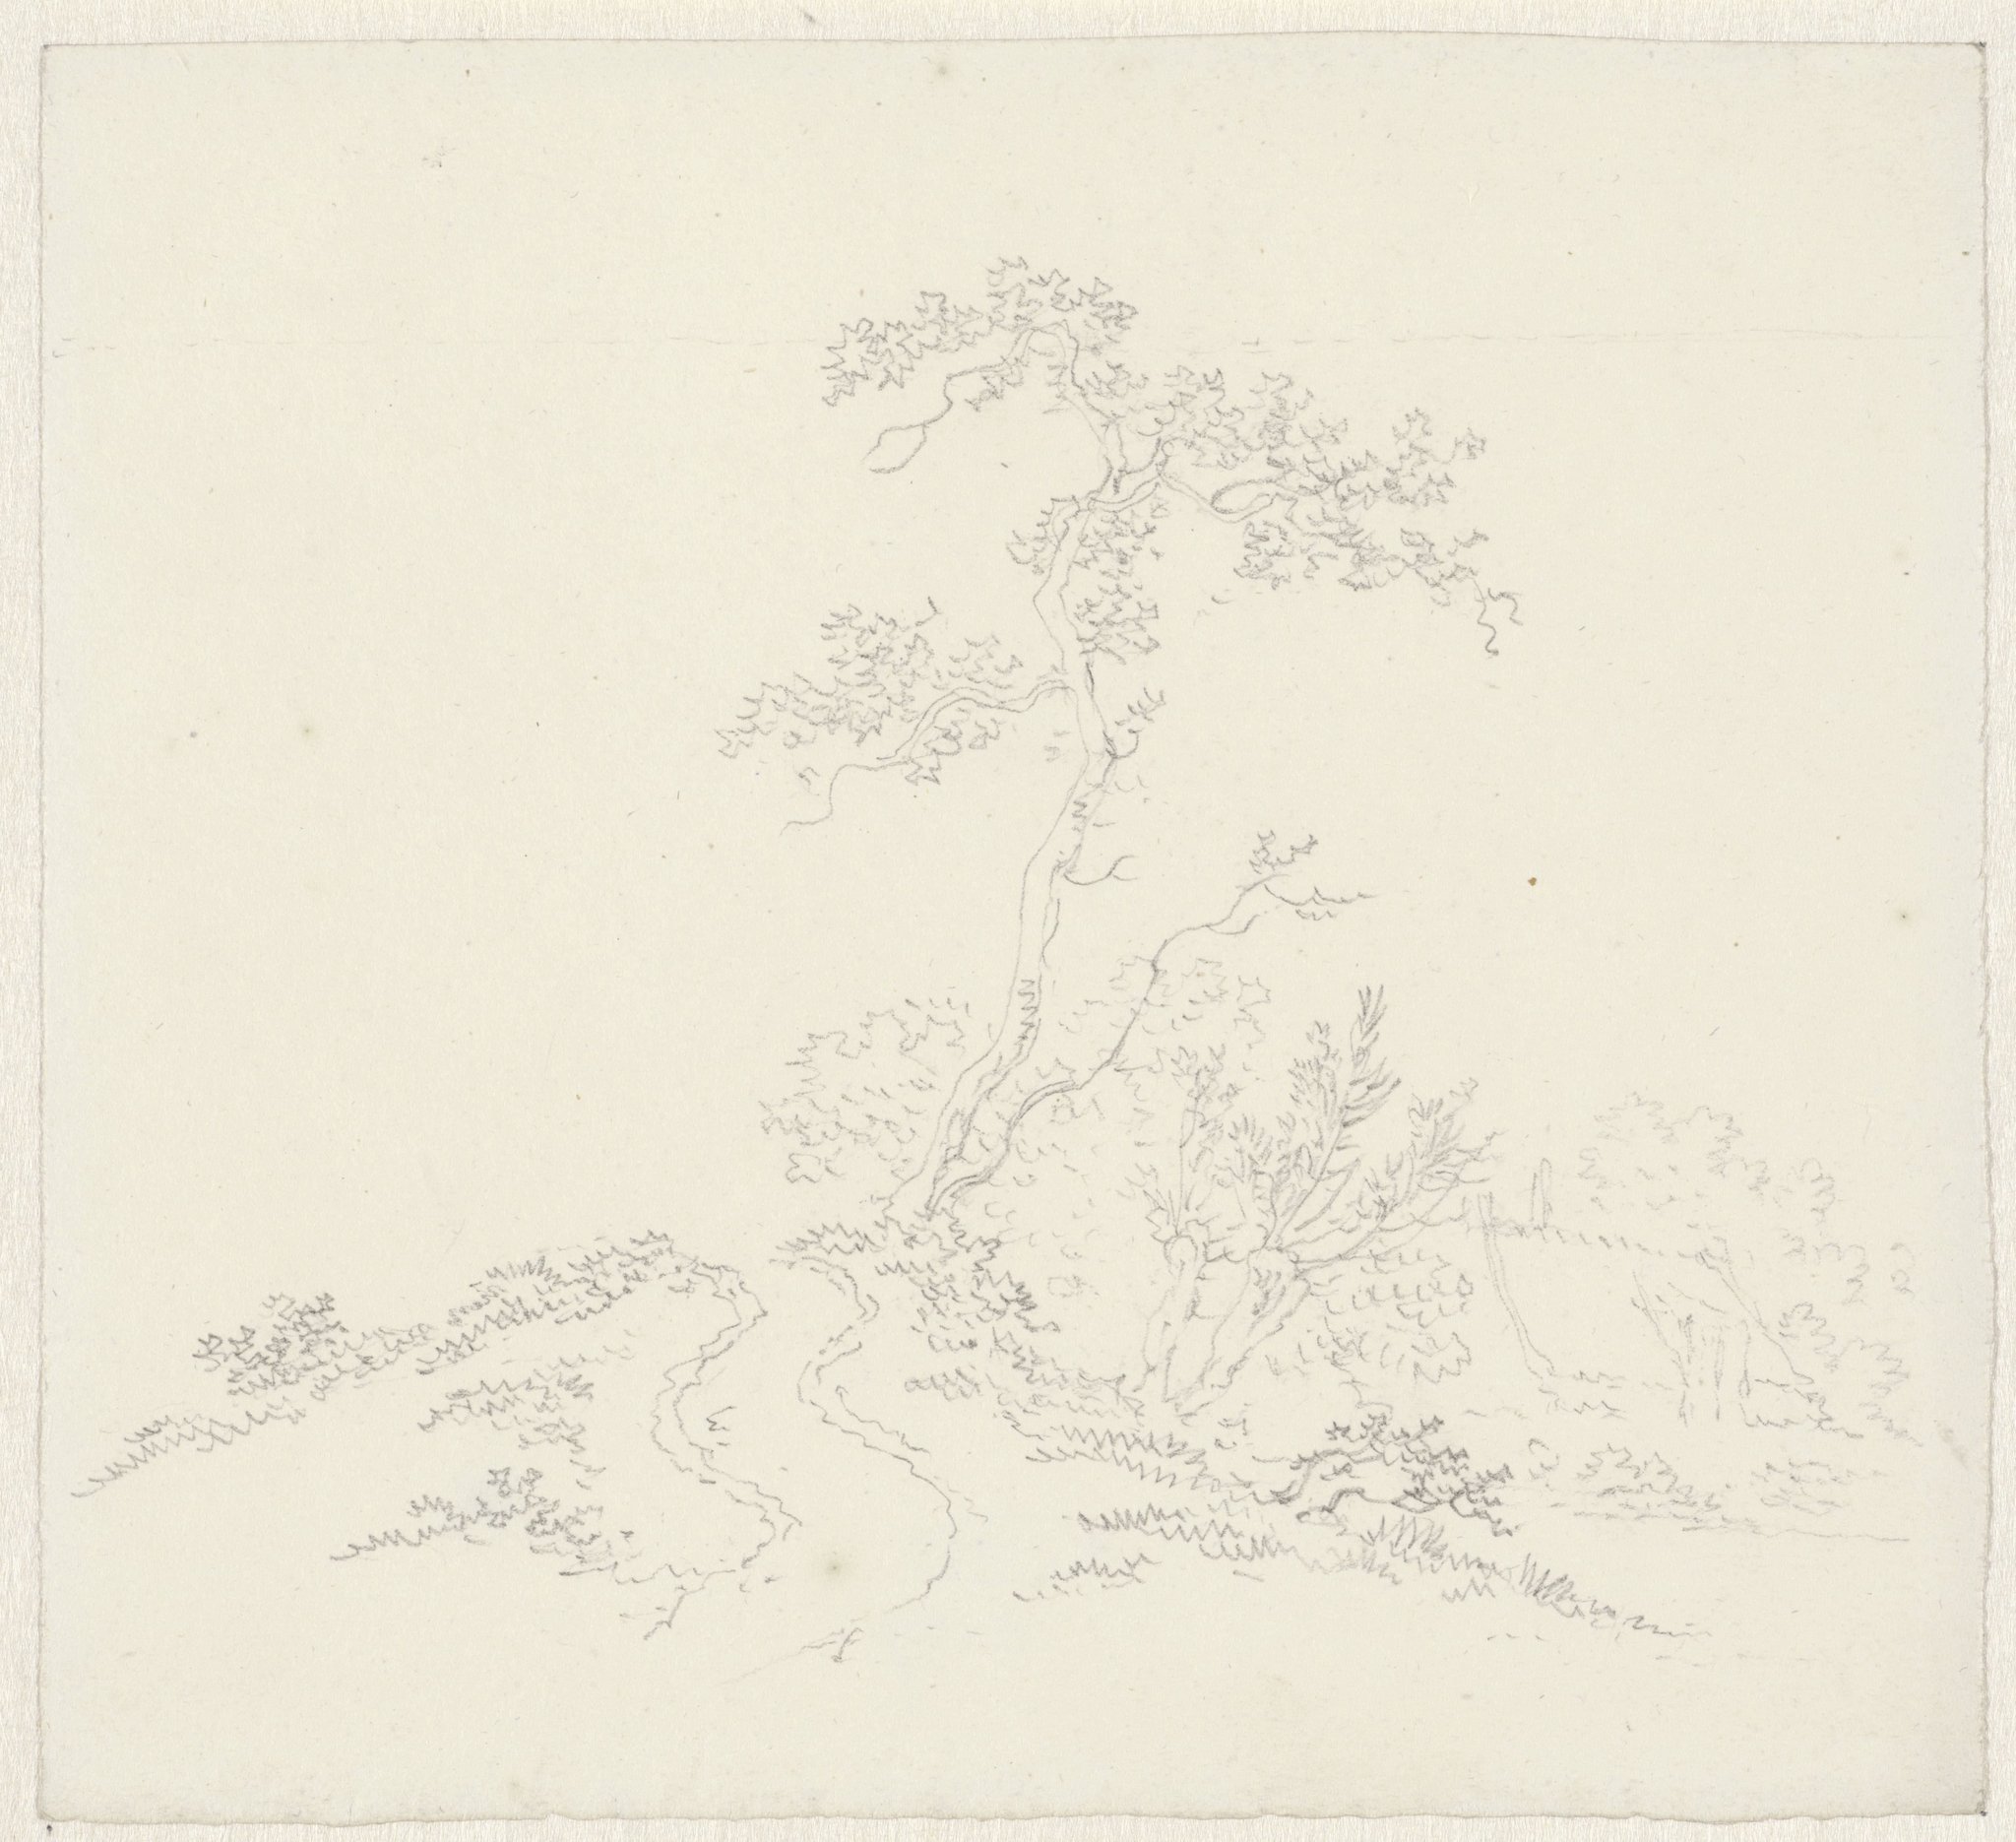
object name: drawing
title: Weggetje langs een boom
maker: pieter de goeje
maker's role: draughtsman, print maker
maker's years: 1789-1859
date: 1789-1859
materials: paper, pencil